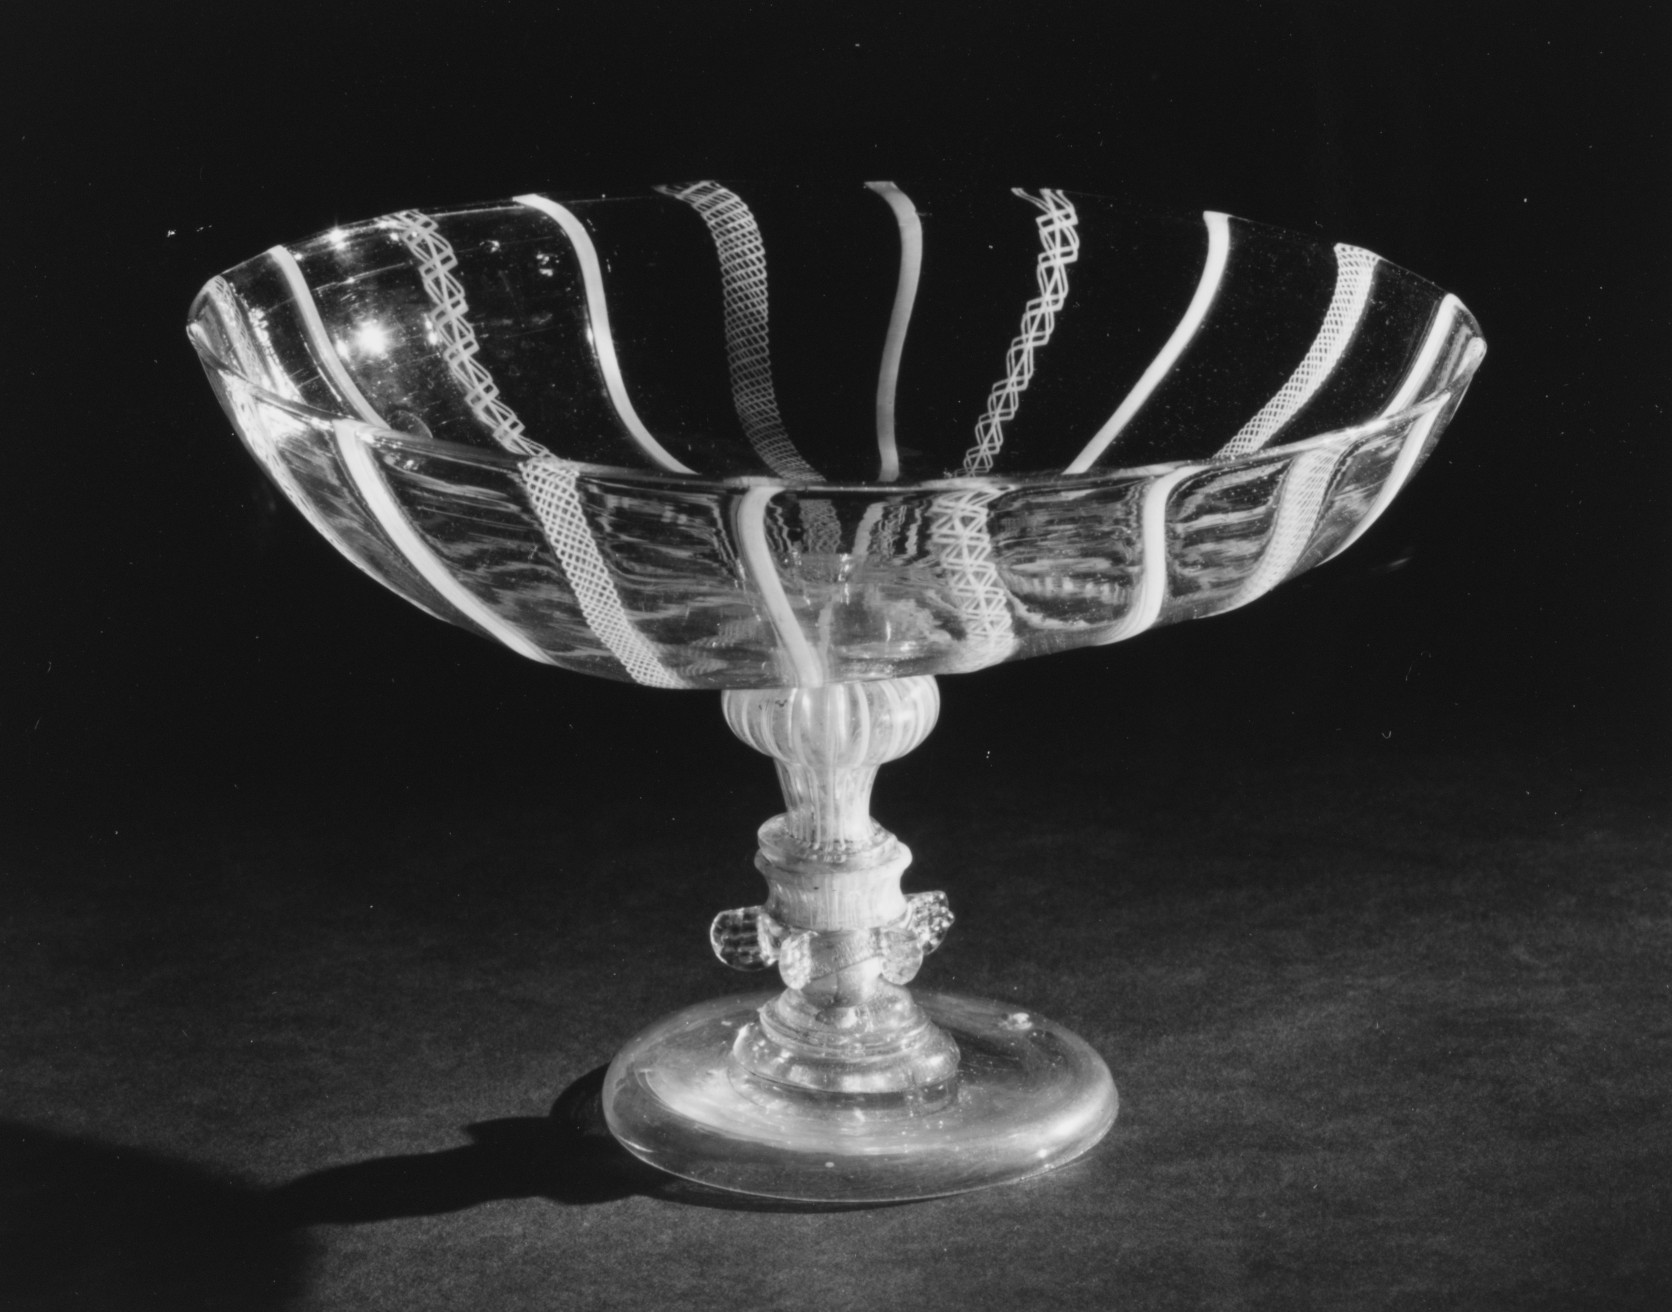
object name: tazza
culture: italian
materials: glass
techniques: glassblowing